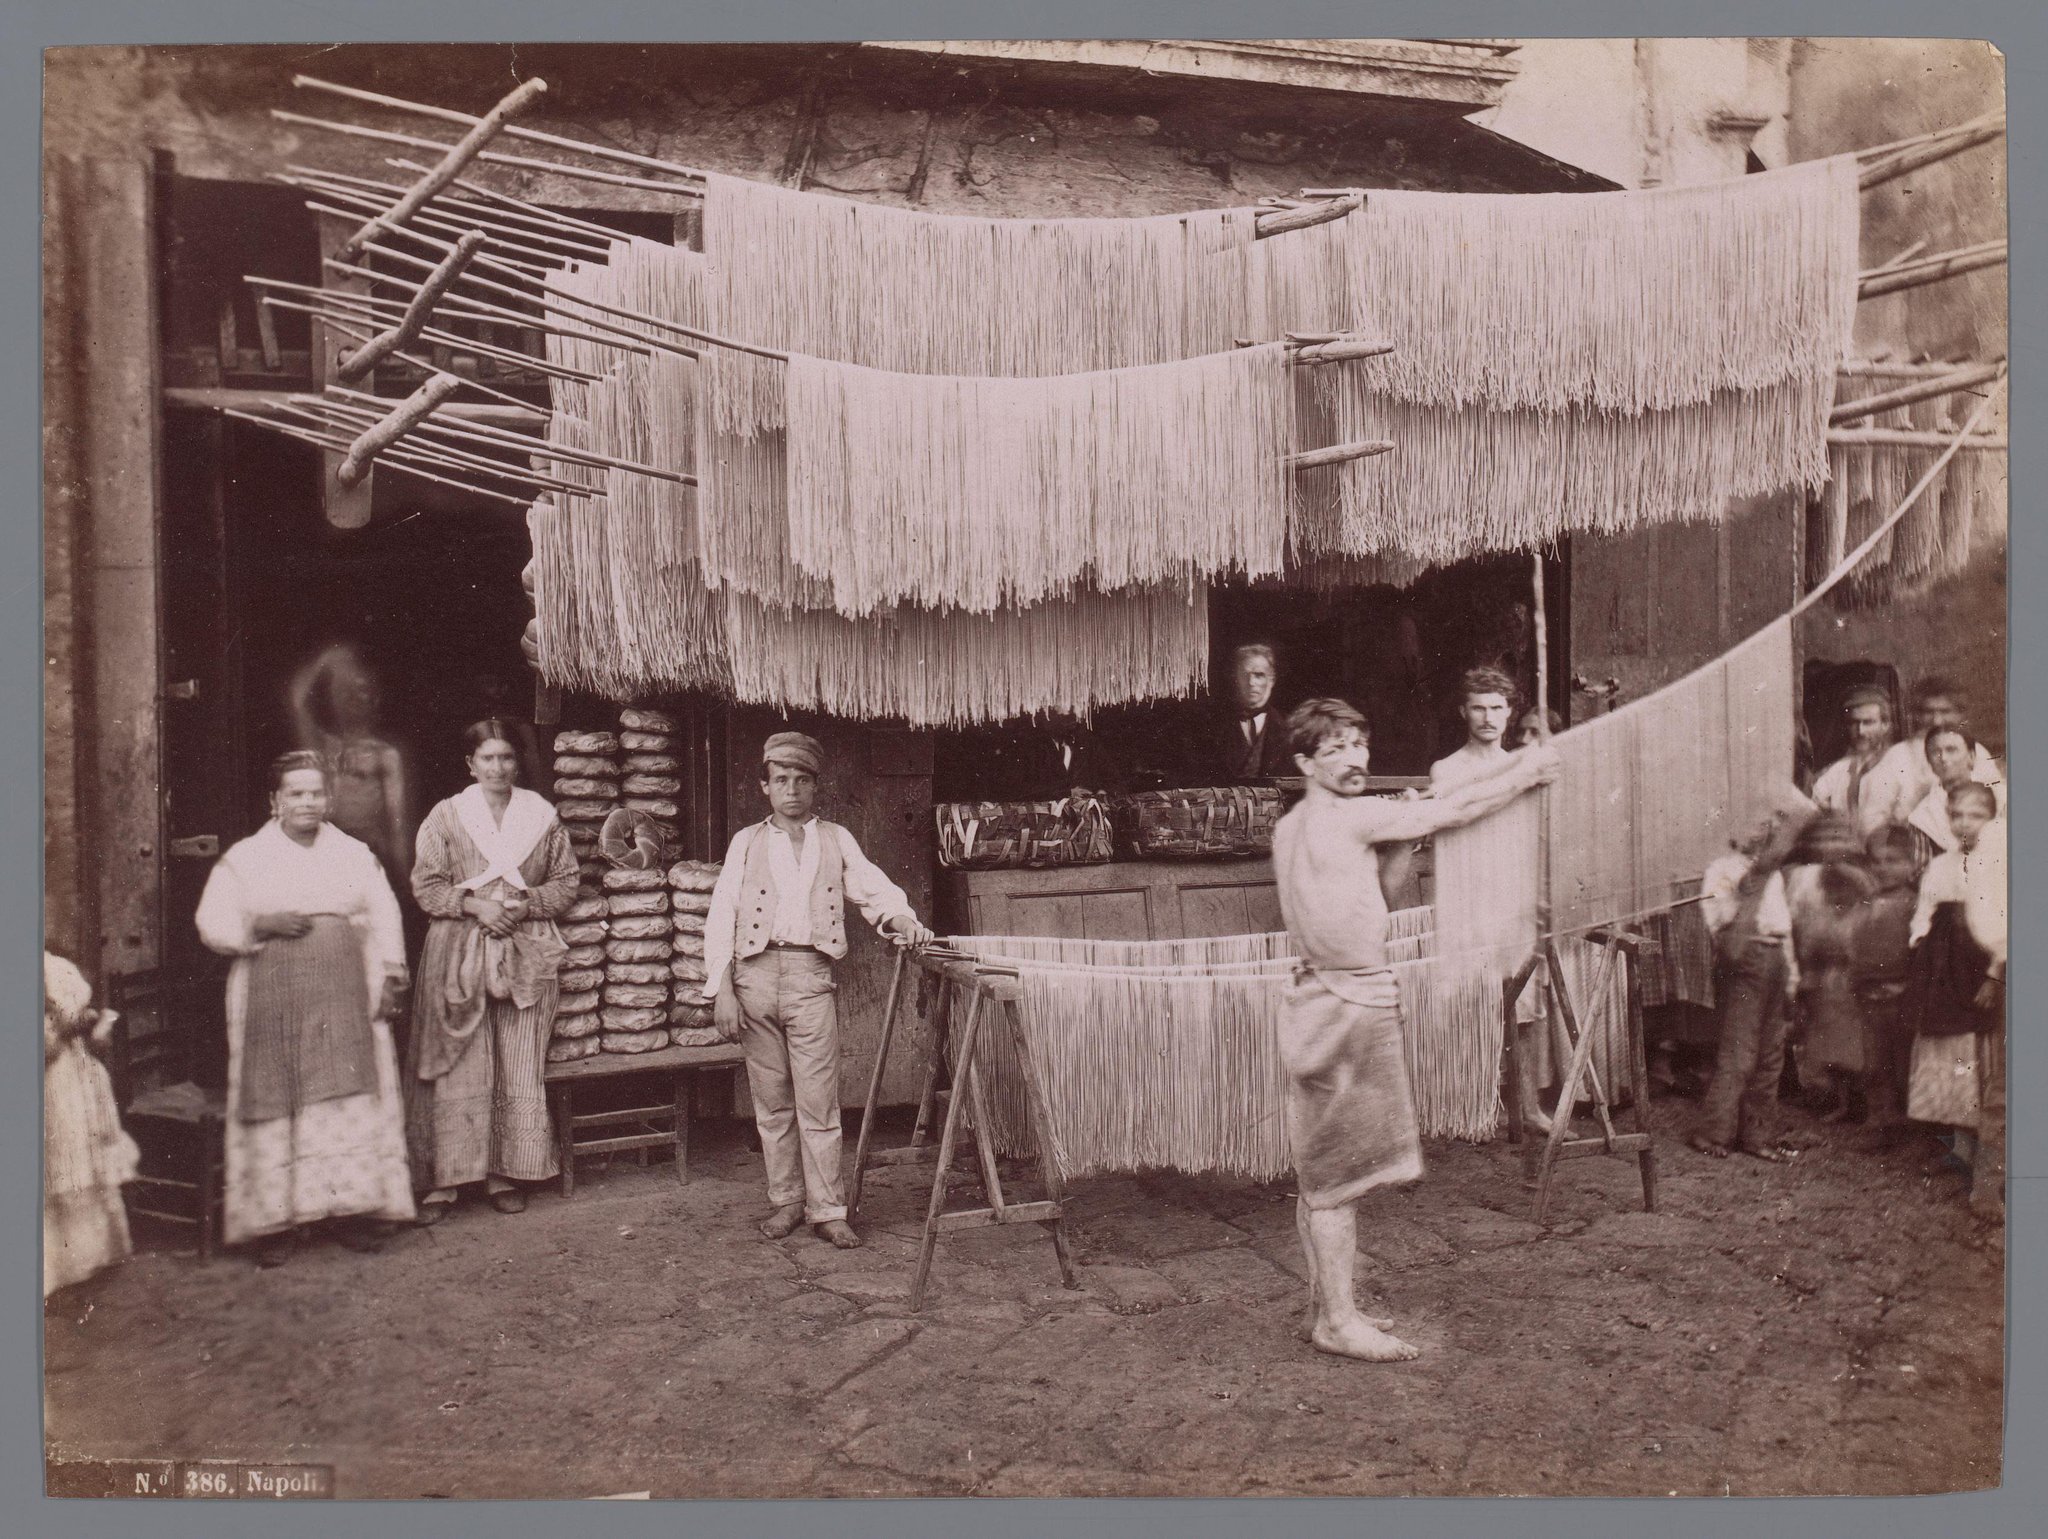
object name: photograph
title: Straatgezicht in Napels met pastamakers en droogrekken voor spaghetti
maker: roberto rive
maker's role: fotograaf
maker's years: 1825-1868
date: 1860-1889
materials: paper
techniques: albumen print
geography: naples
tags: noodles, spaghetti, etc., workshop, street (+ city(-scape) with figures, staffage), naples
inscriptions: stamp: ‘Rive[...]’, number: ‘No. 386.’, inscription: ‘Rive (t)’